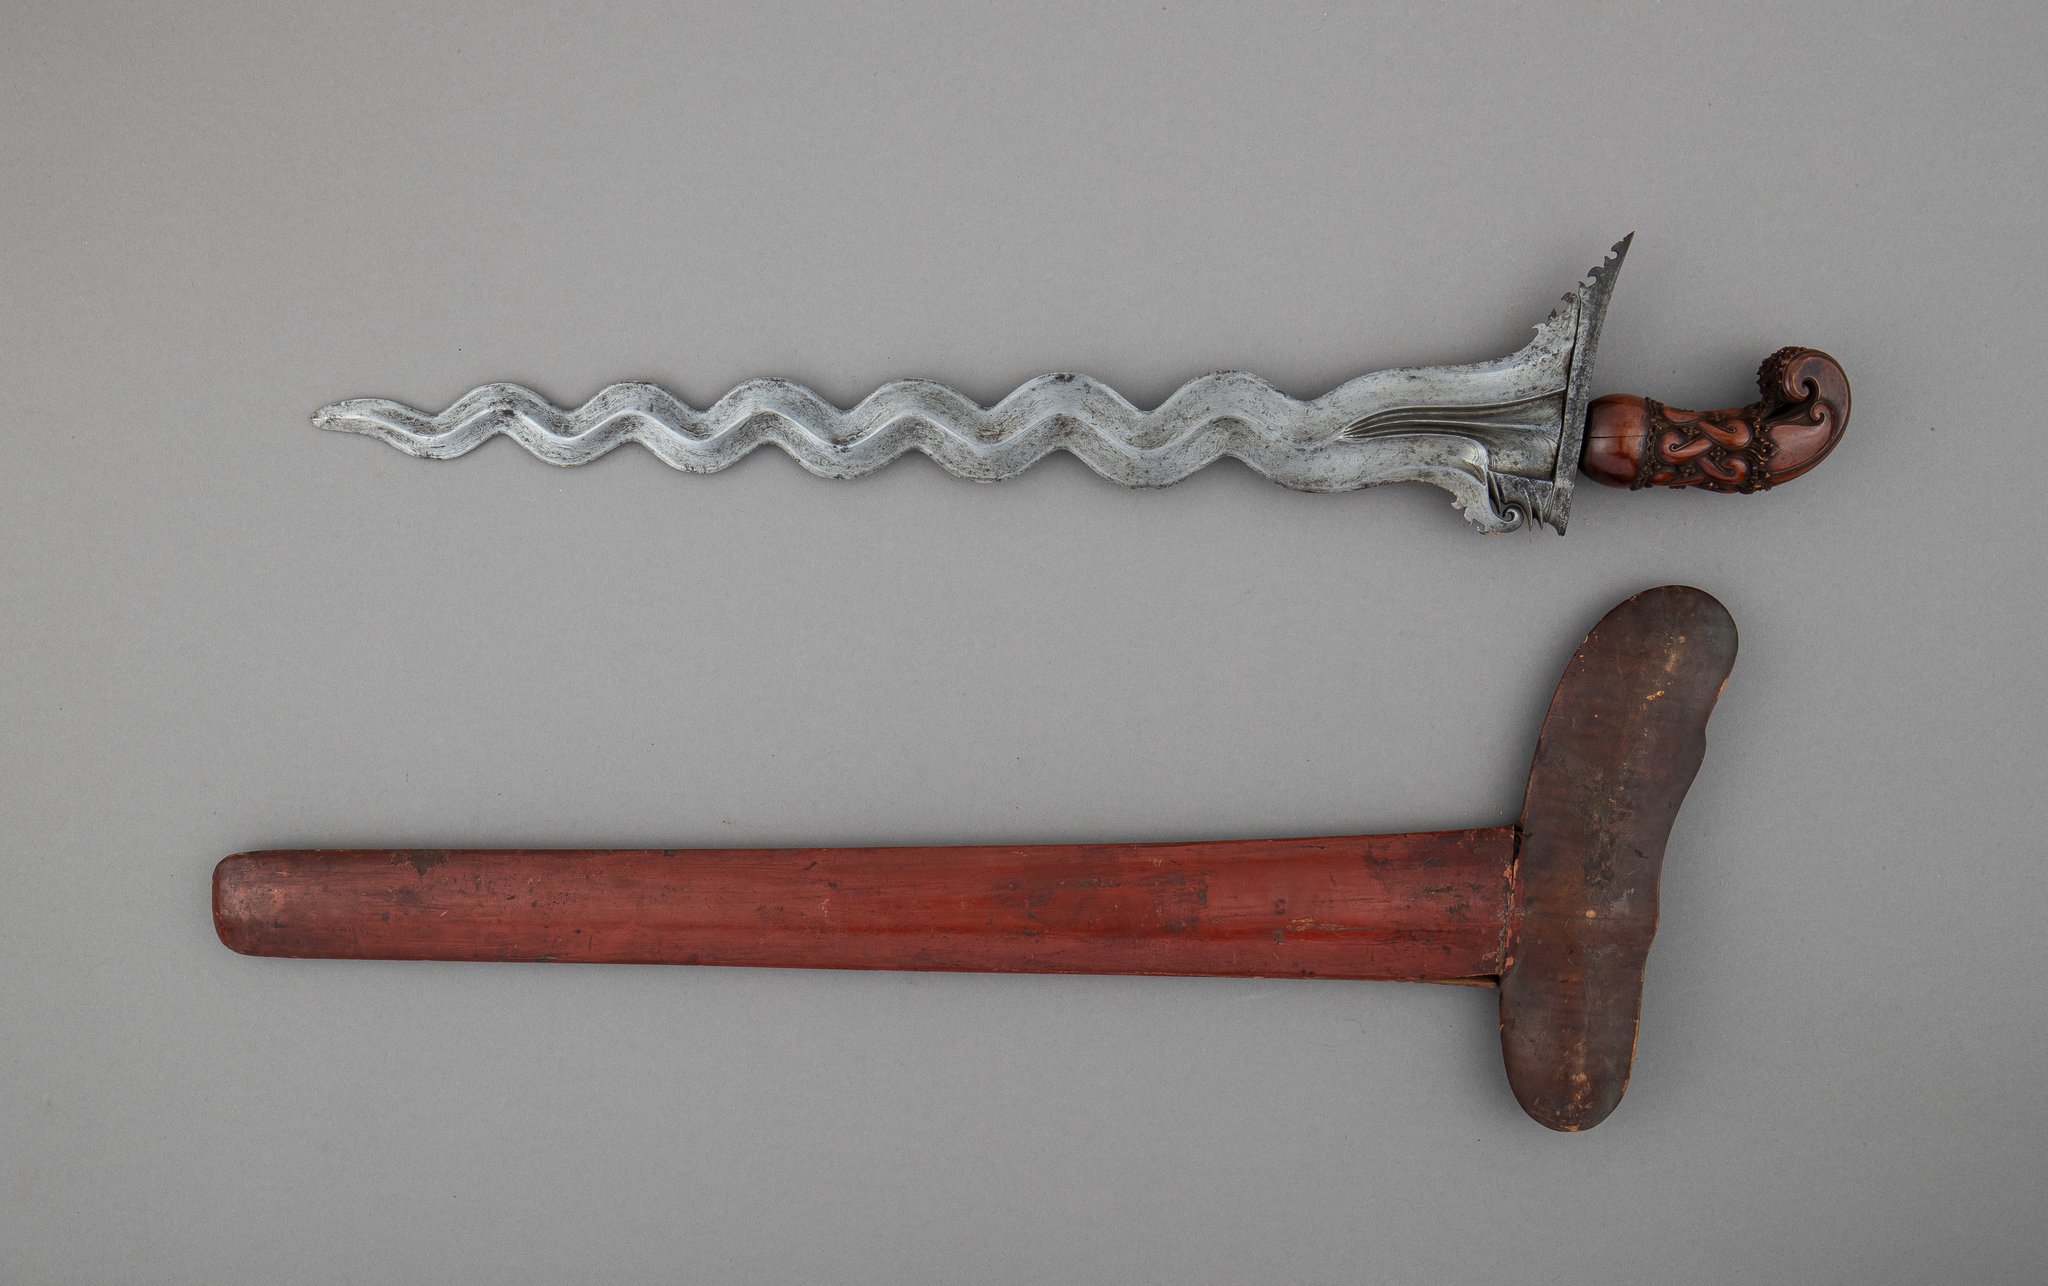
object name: kris with sheath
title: Kris (Kris Cherita) with Sheath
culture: balinese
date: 1501-1900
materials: pigment, steel, wood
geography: indonesia